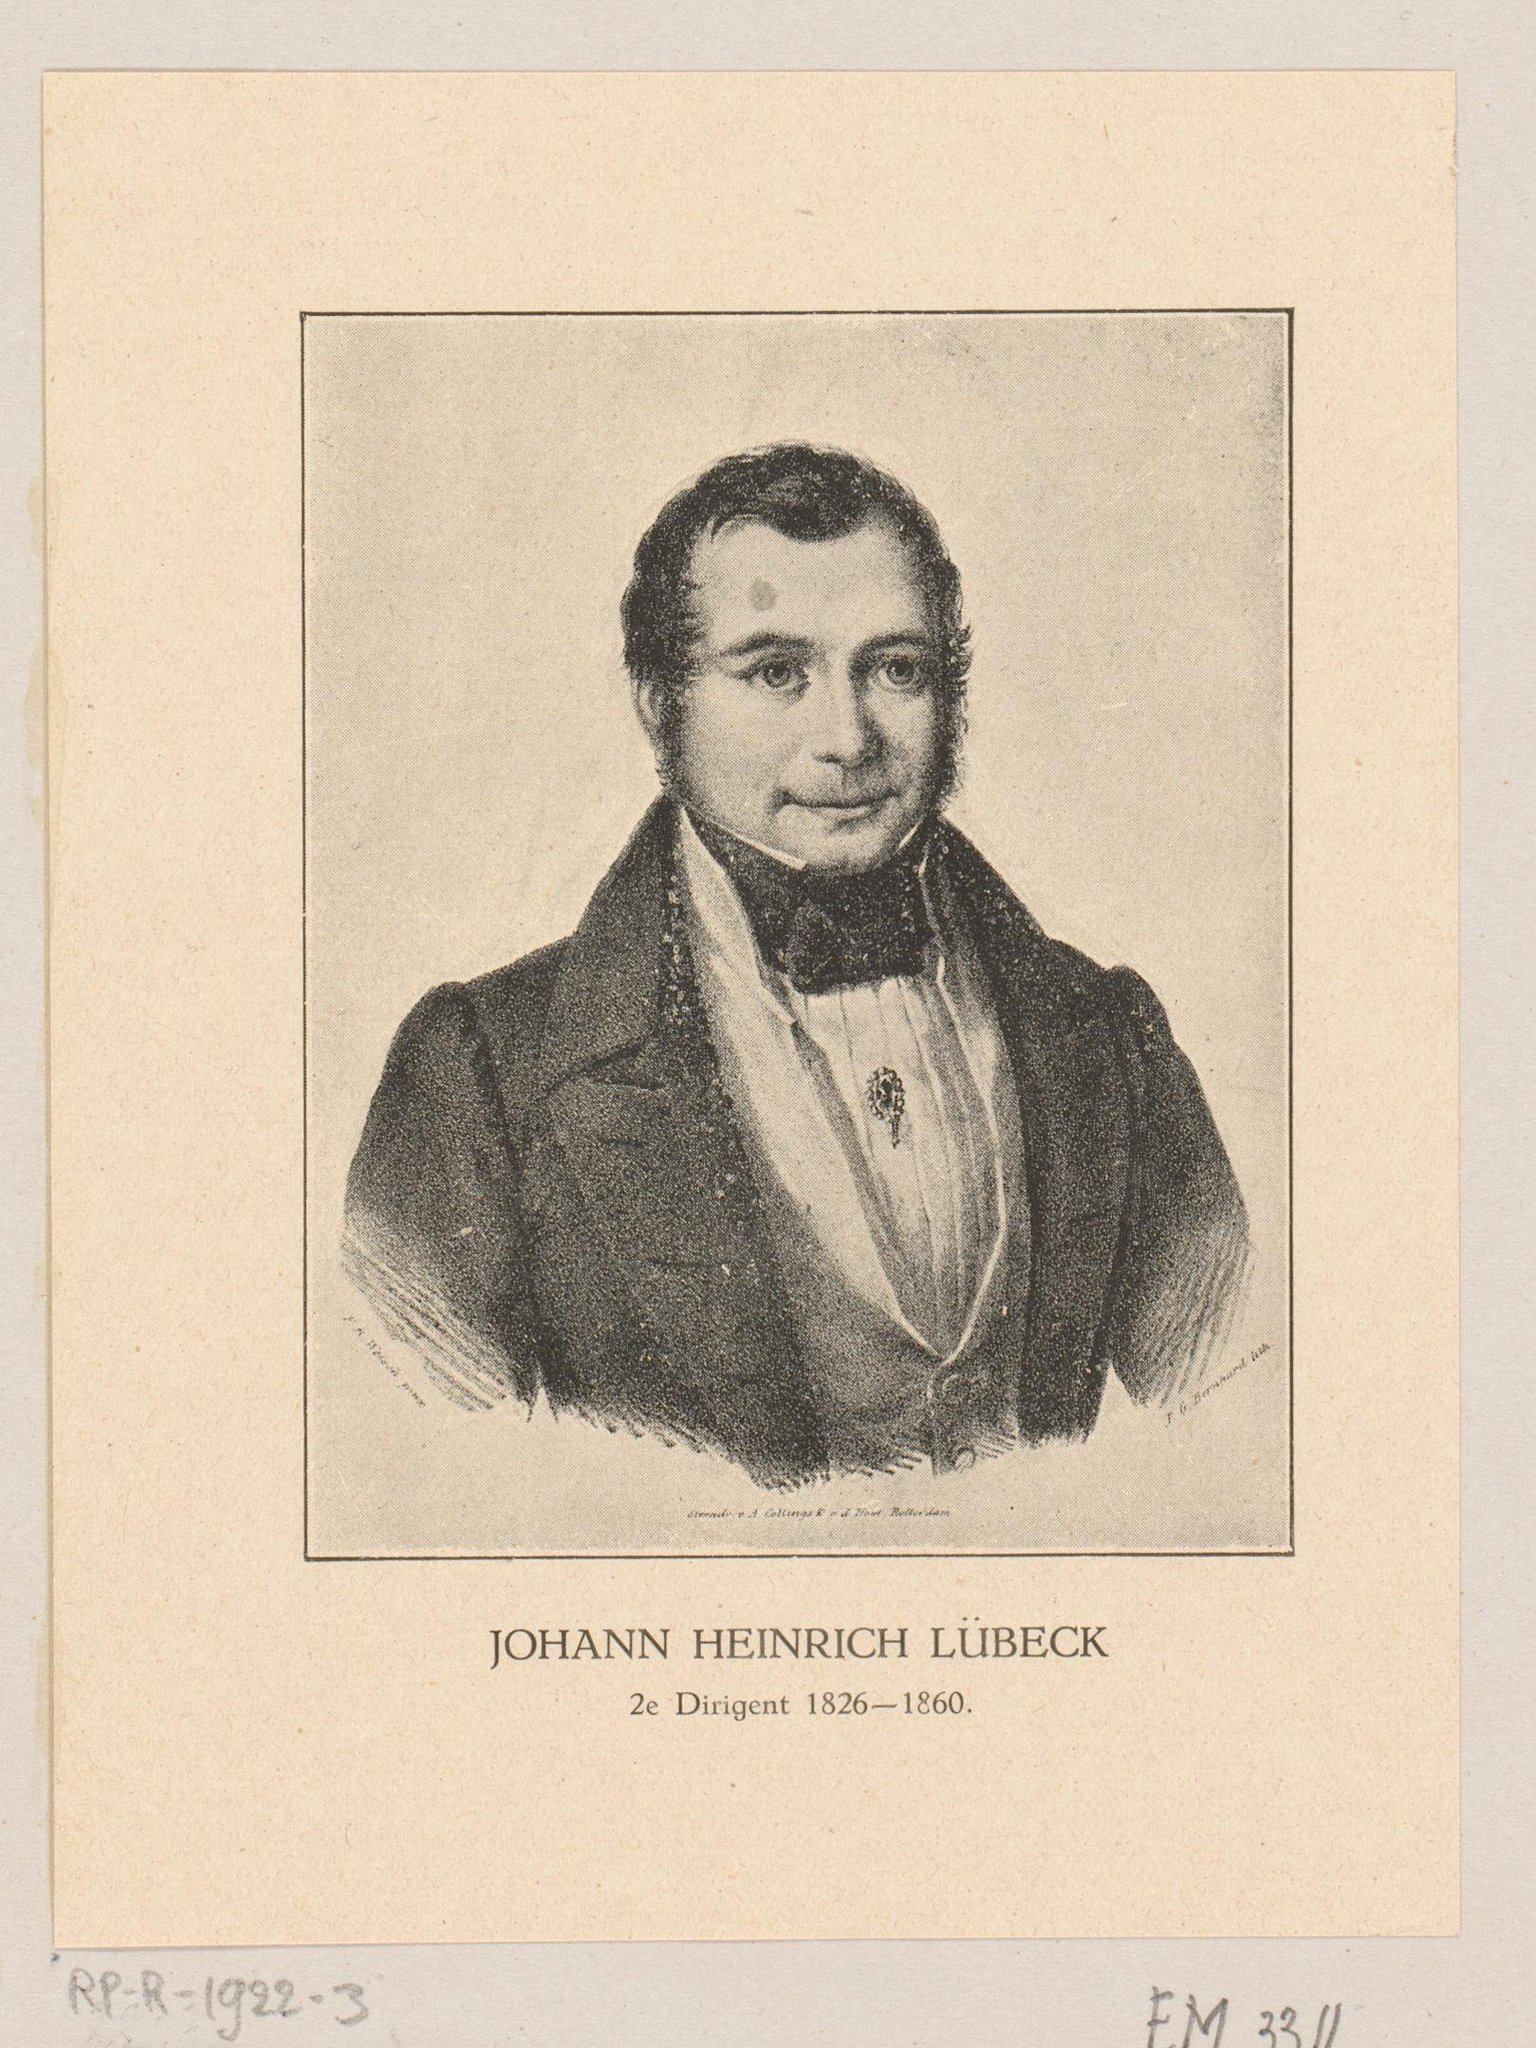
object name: reproduction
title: Portret van Johann Heinrich Lubeck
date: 1882-1922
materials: paper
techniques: autotype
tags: historical persons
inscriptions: collector's mark: Lugt 2233